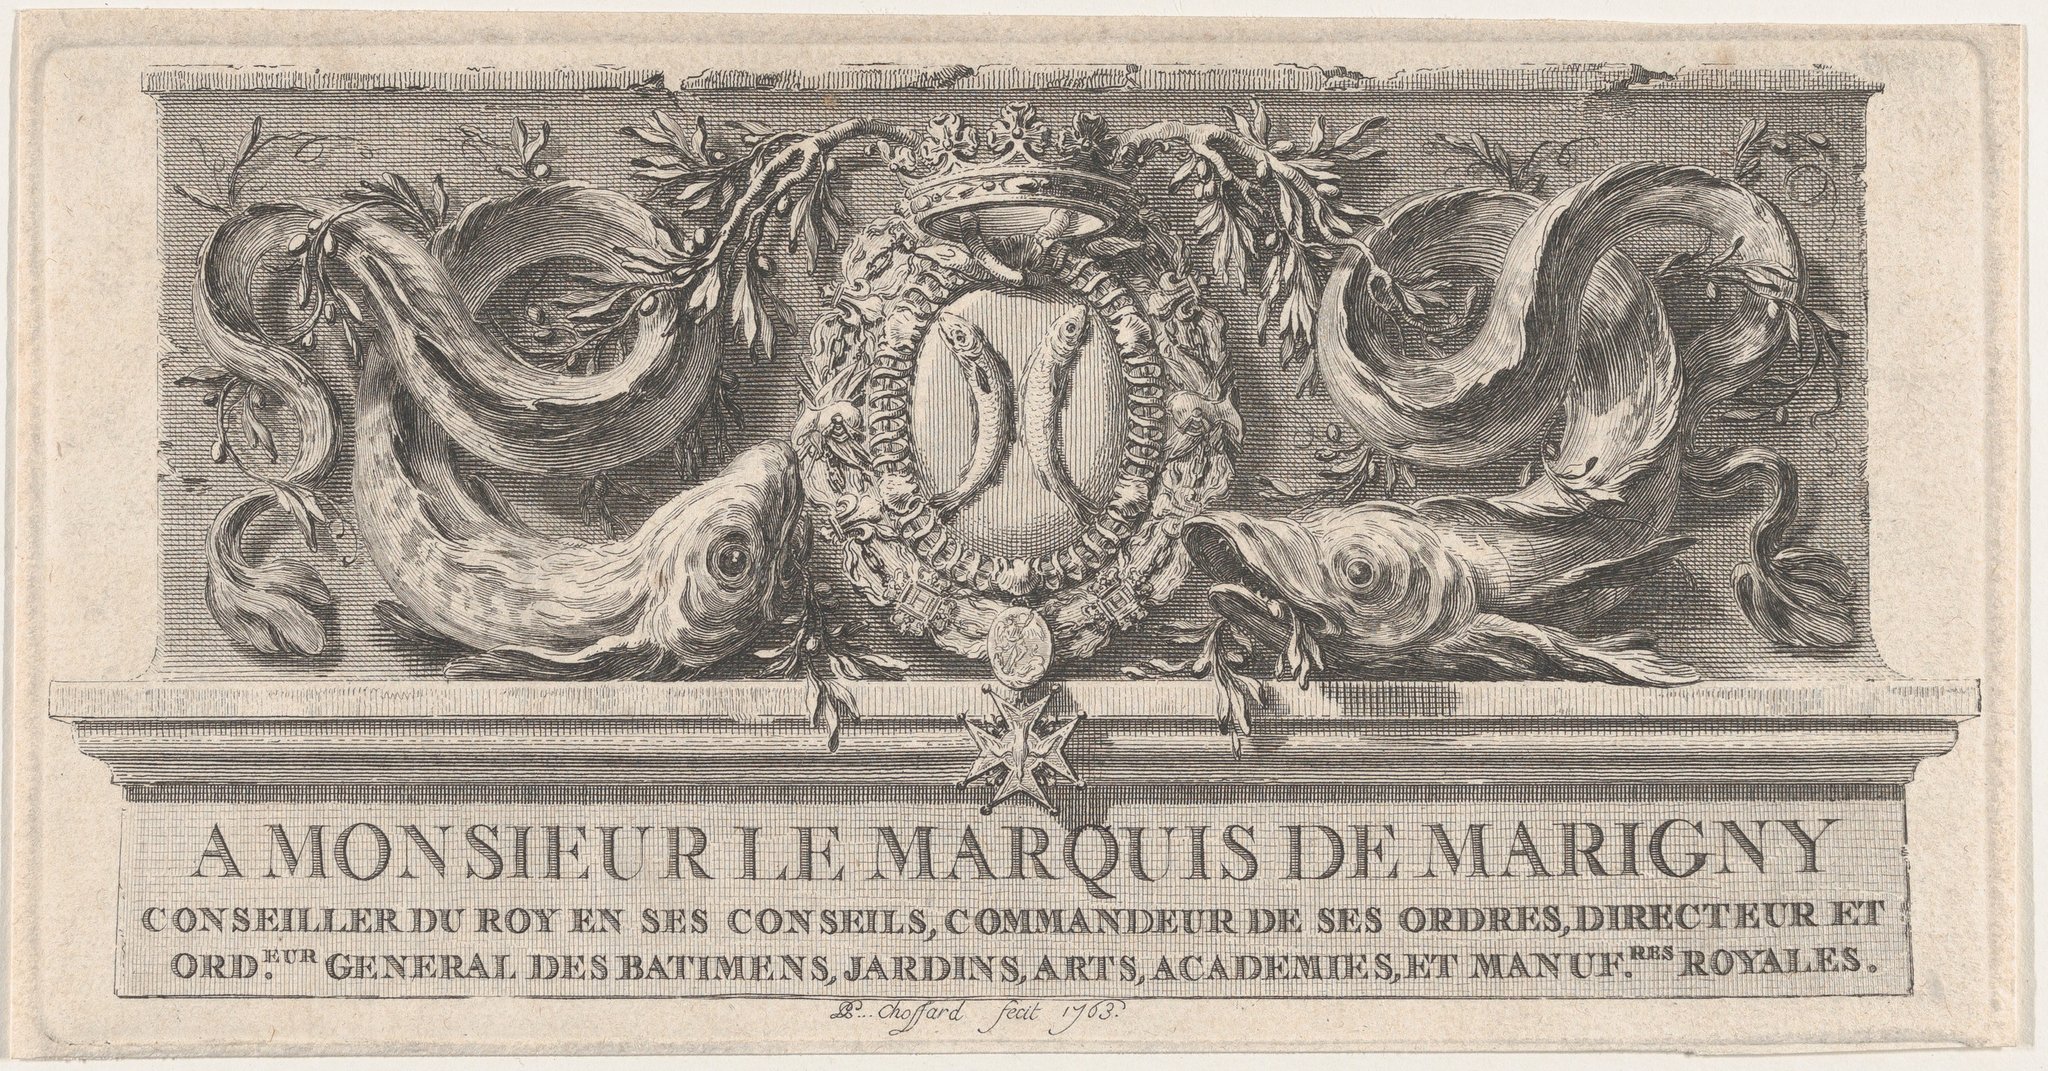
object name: print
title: Coat of Arms of the Marquis de Marigny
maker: pierre philippe choffard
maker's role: artist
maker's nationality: french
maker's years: 1730-1809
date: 1763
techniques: engraving